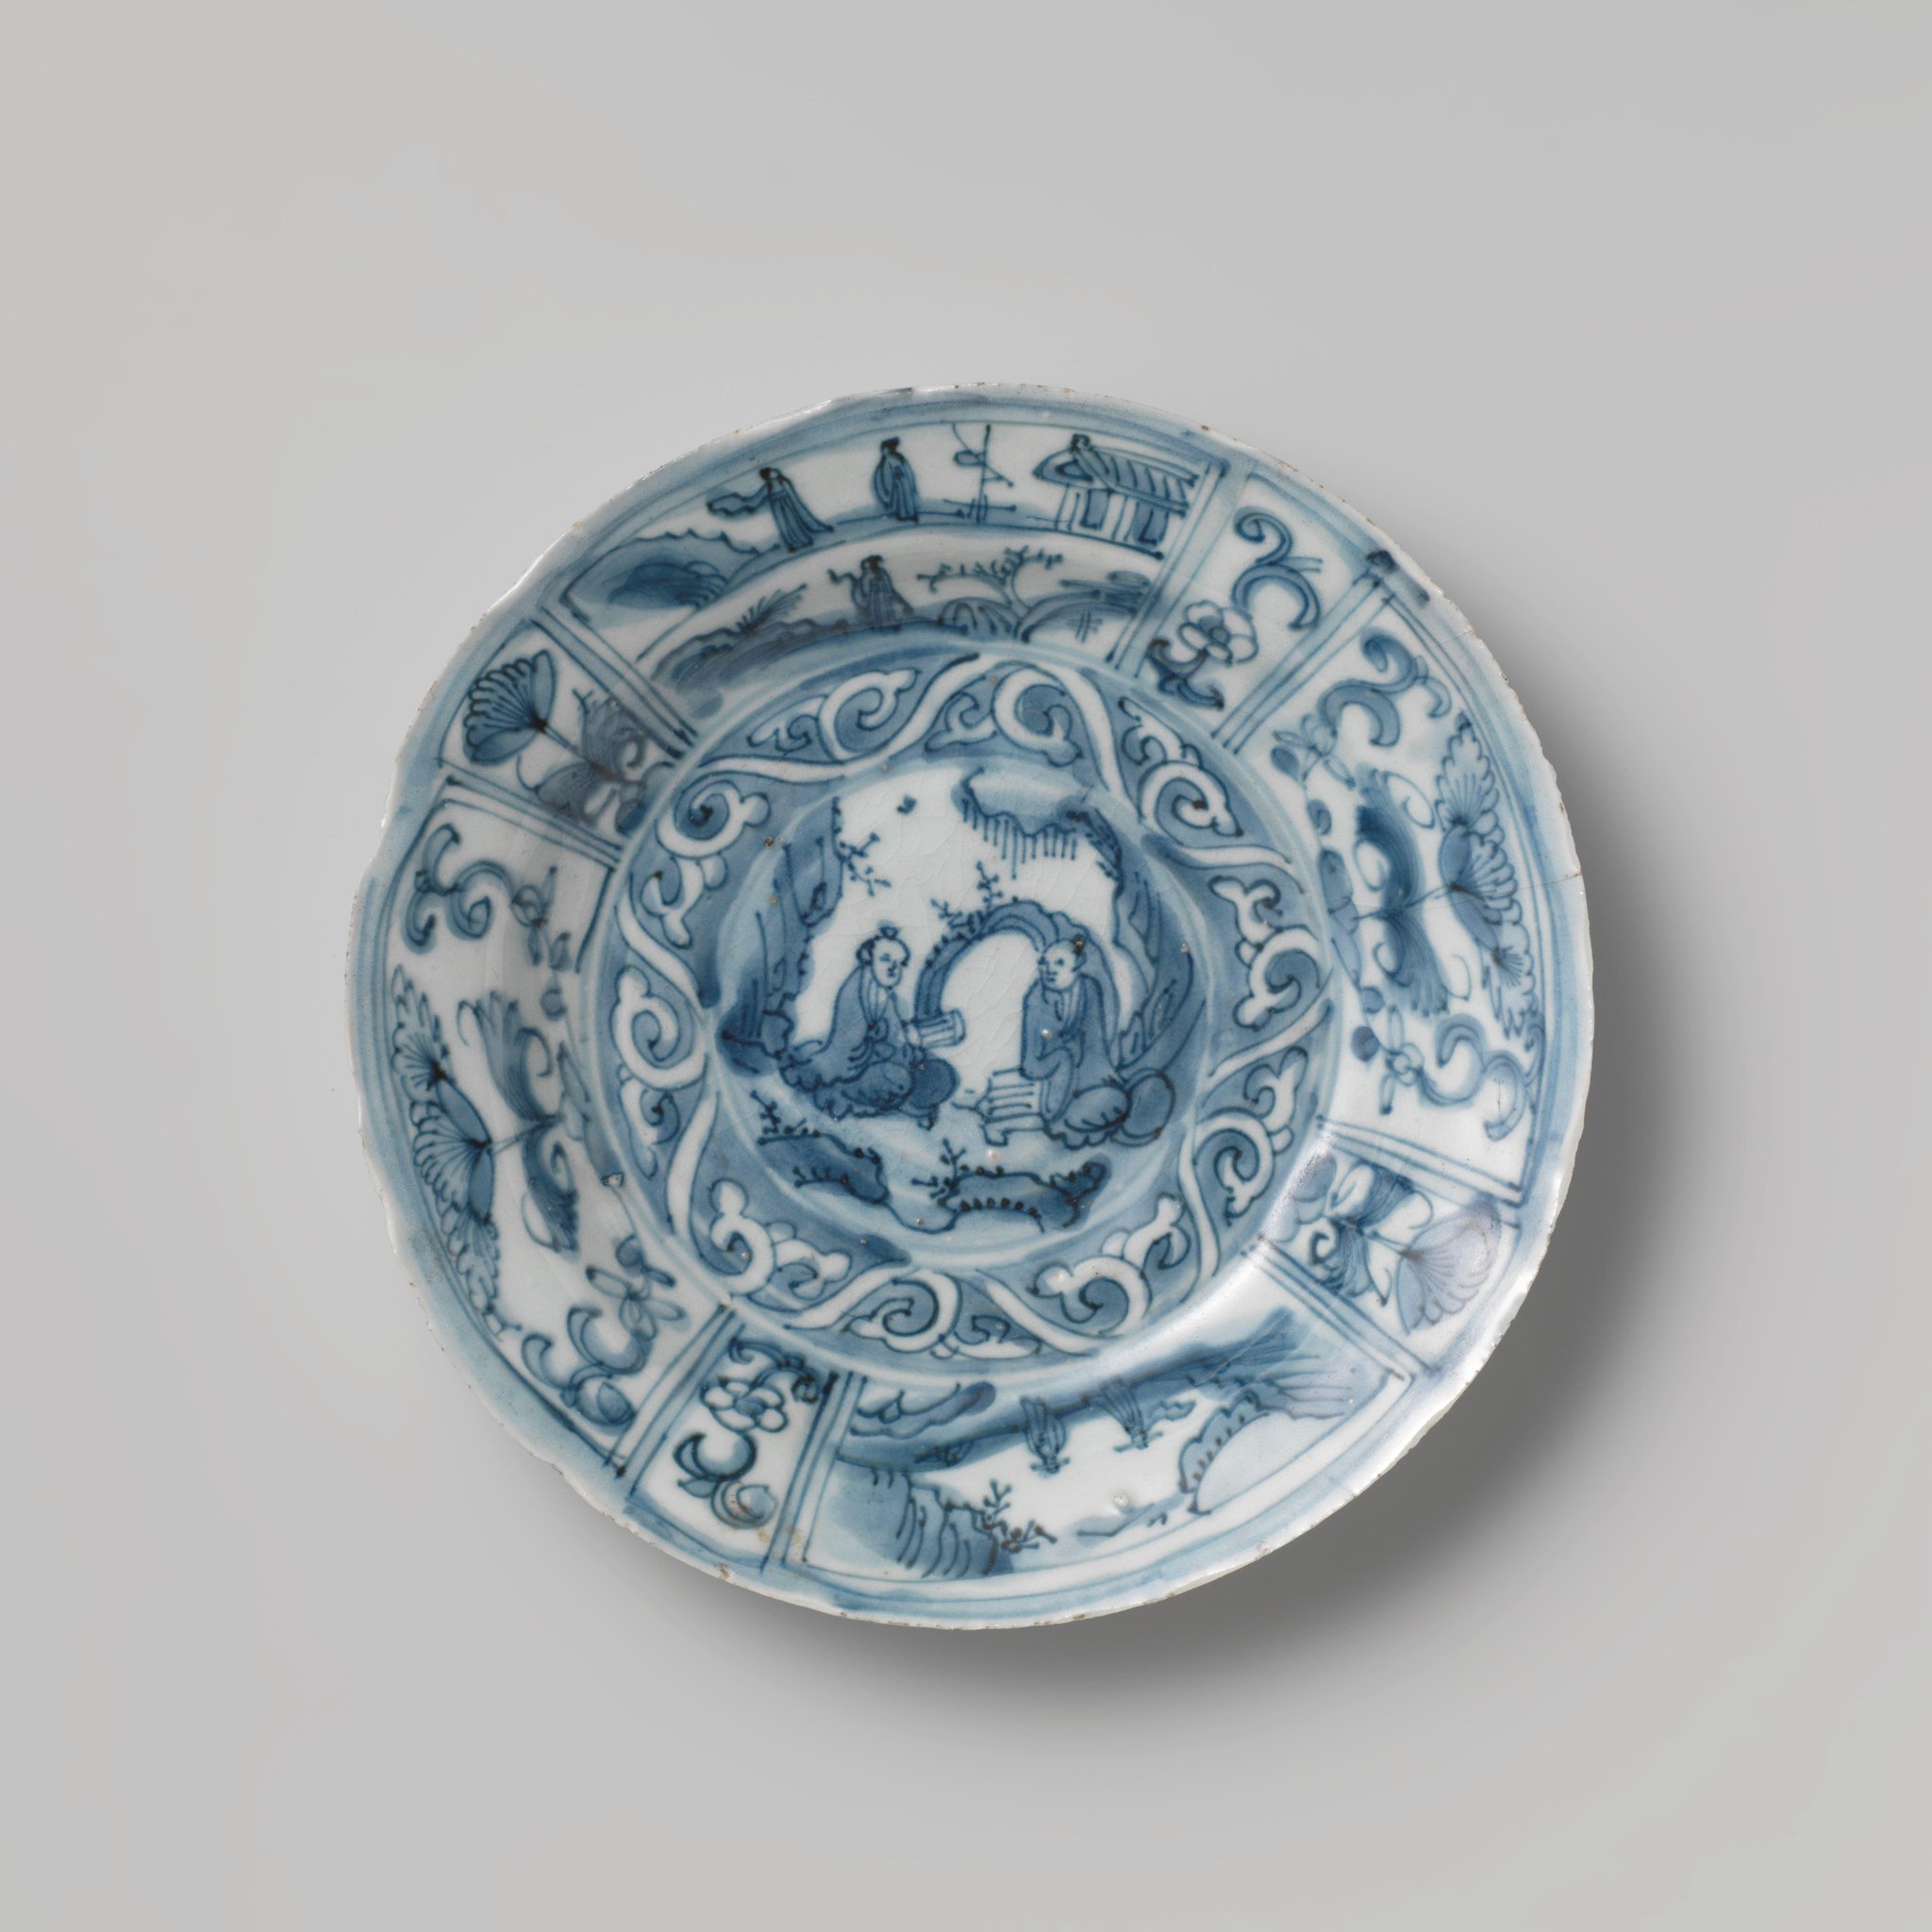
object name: plate dish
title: Plate with two Chinese figures in a landscape, floral scrolls and a panel decoration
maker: Anonymous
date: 1625-1675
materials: cobalt, glaze, paint, porcelain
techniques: firing, turning, vitrification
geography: arita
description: Bord van porselein met een geschulpte rand, beschilderd in onderglazuur blauw. Op het plat een medaillon met twee zittende Chinese personen in een landschap; om het medaillon een band met ranken. De wand en rand zijn verdeeld in brede en smalle vakken. De brede vakken met personen in een landschap of bloemranken, de smalle vakken met bloemranken. De achterwand met twee gestileerde ranken. Een barst in de wand. De decoratie is gebaseerd op Chinees kraakporselein. Bakzand aan de voetring. Arita, blauw-wit.